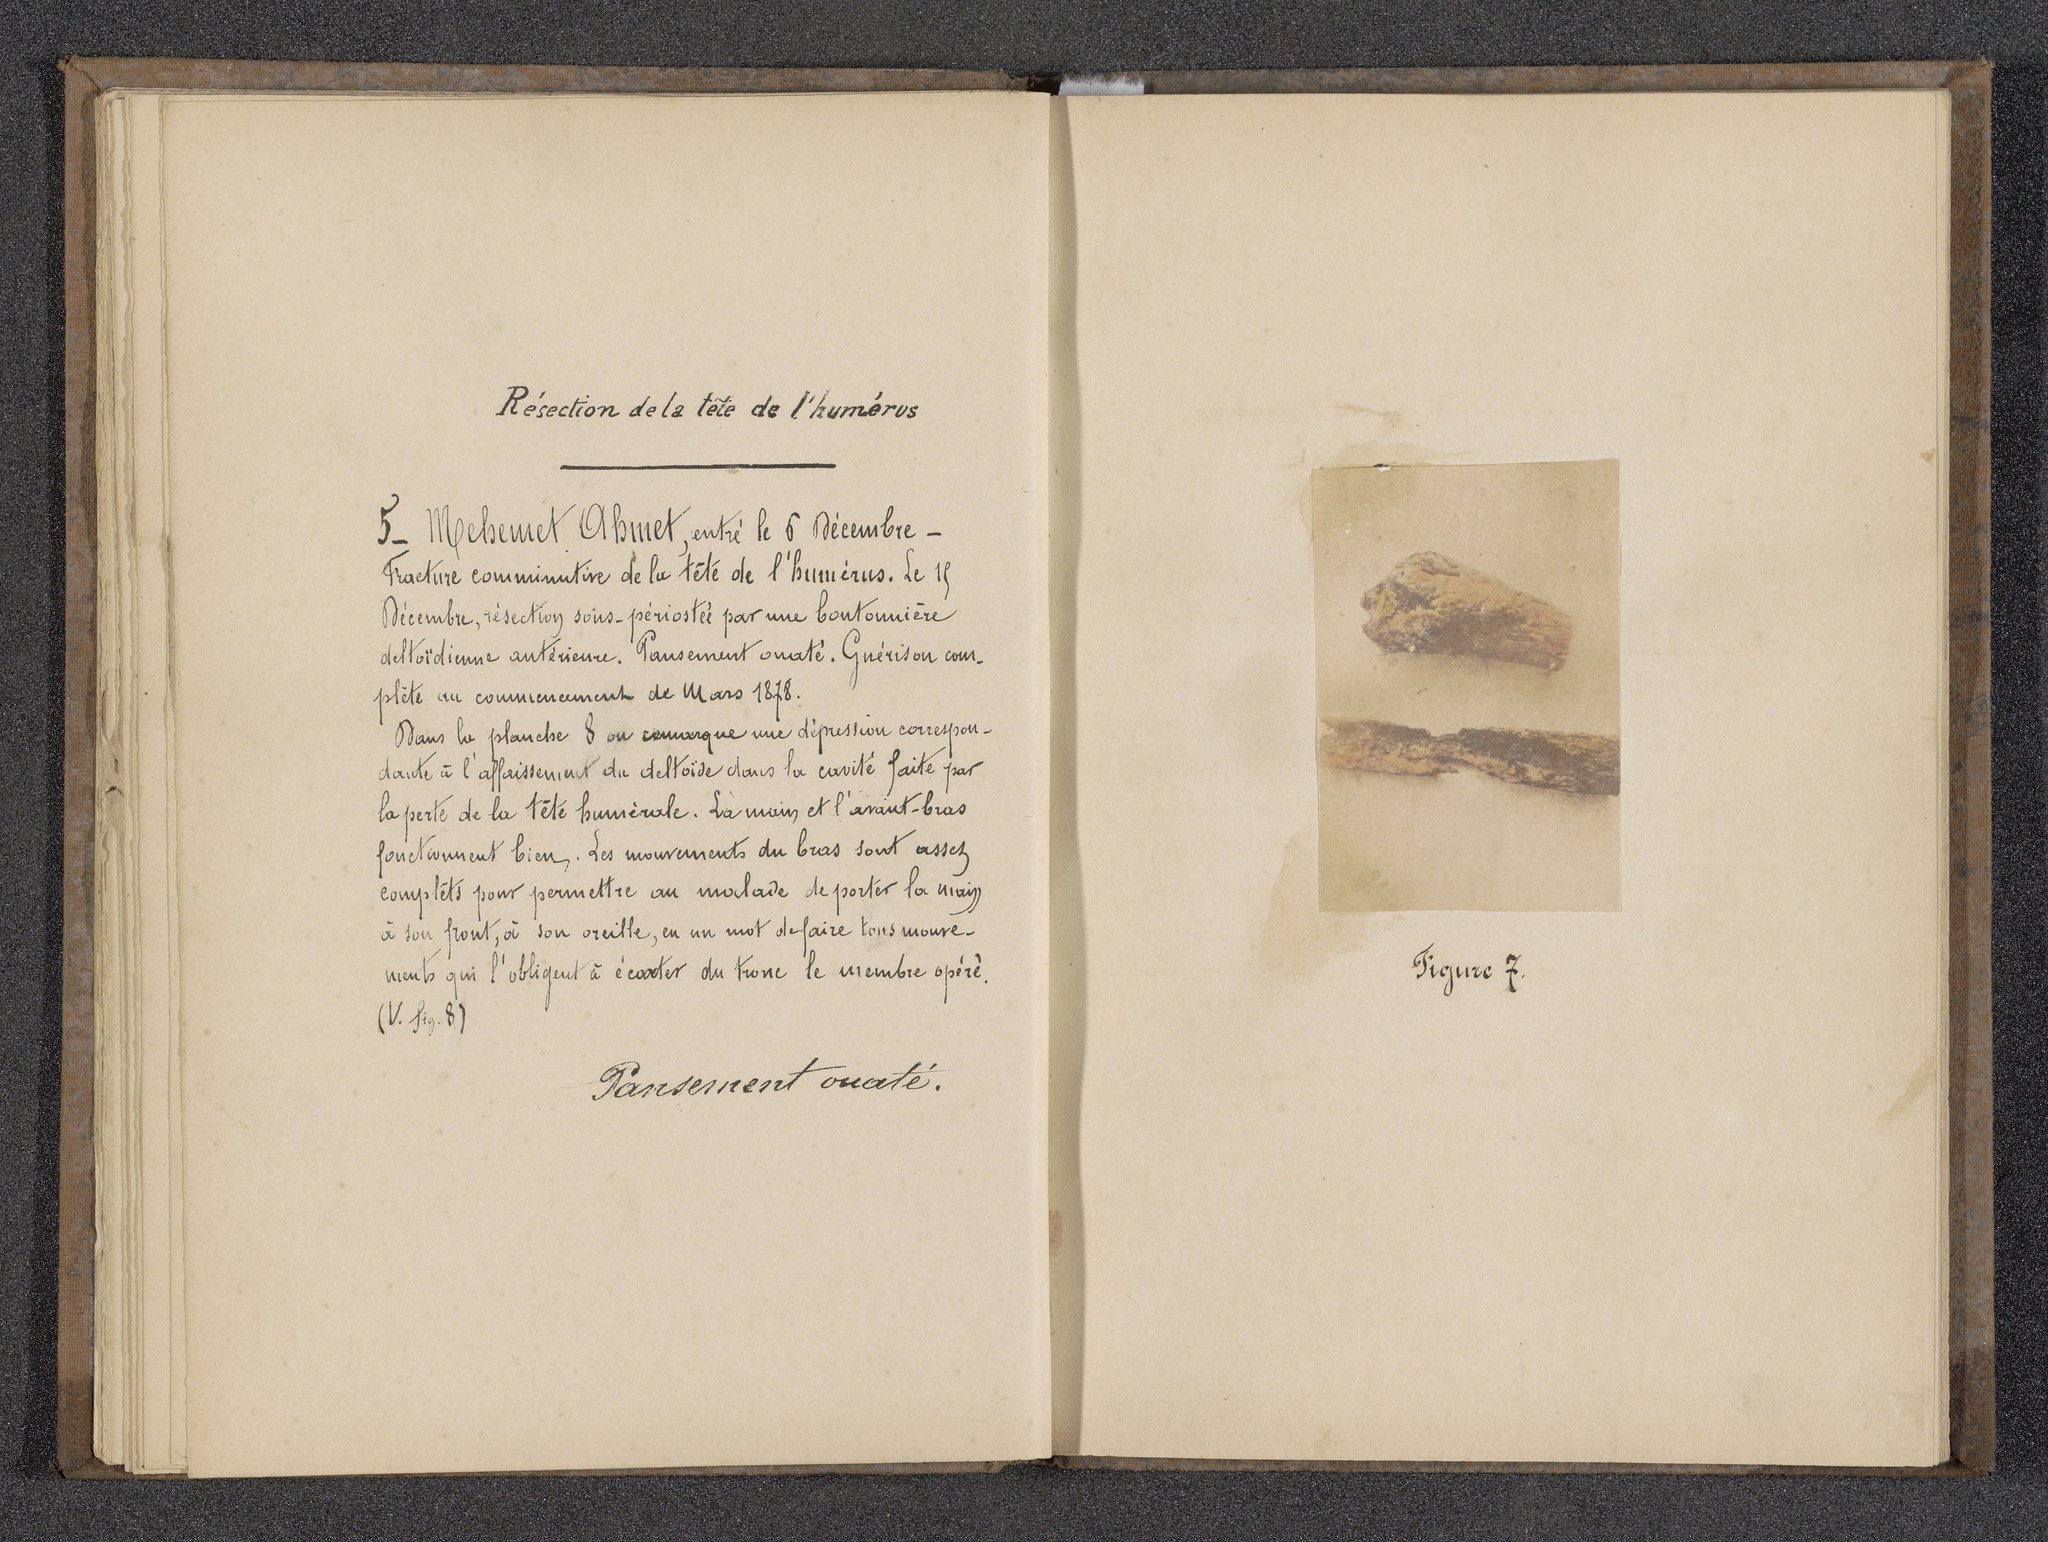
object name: photograph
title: Delen van een opperarmbeen na amputatie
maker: Anonymous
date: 1878-1880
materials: photographic support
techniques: albumen print, hand coloring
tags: humerus, bone of the upper arm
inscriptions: number: ‘Figure 7.’